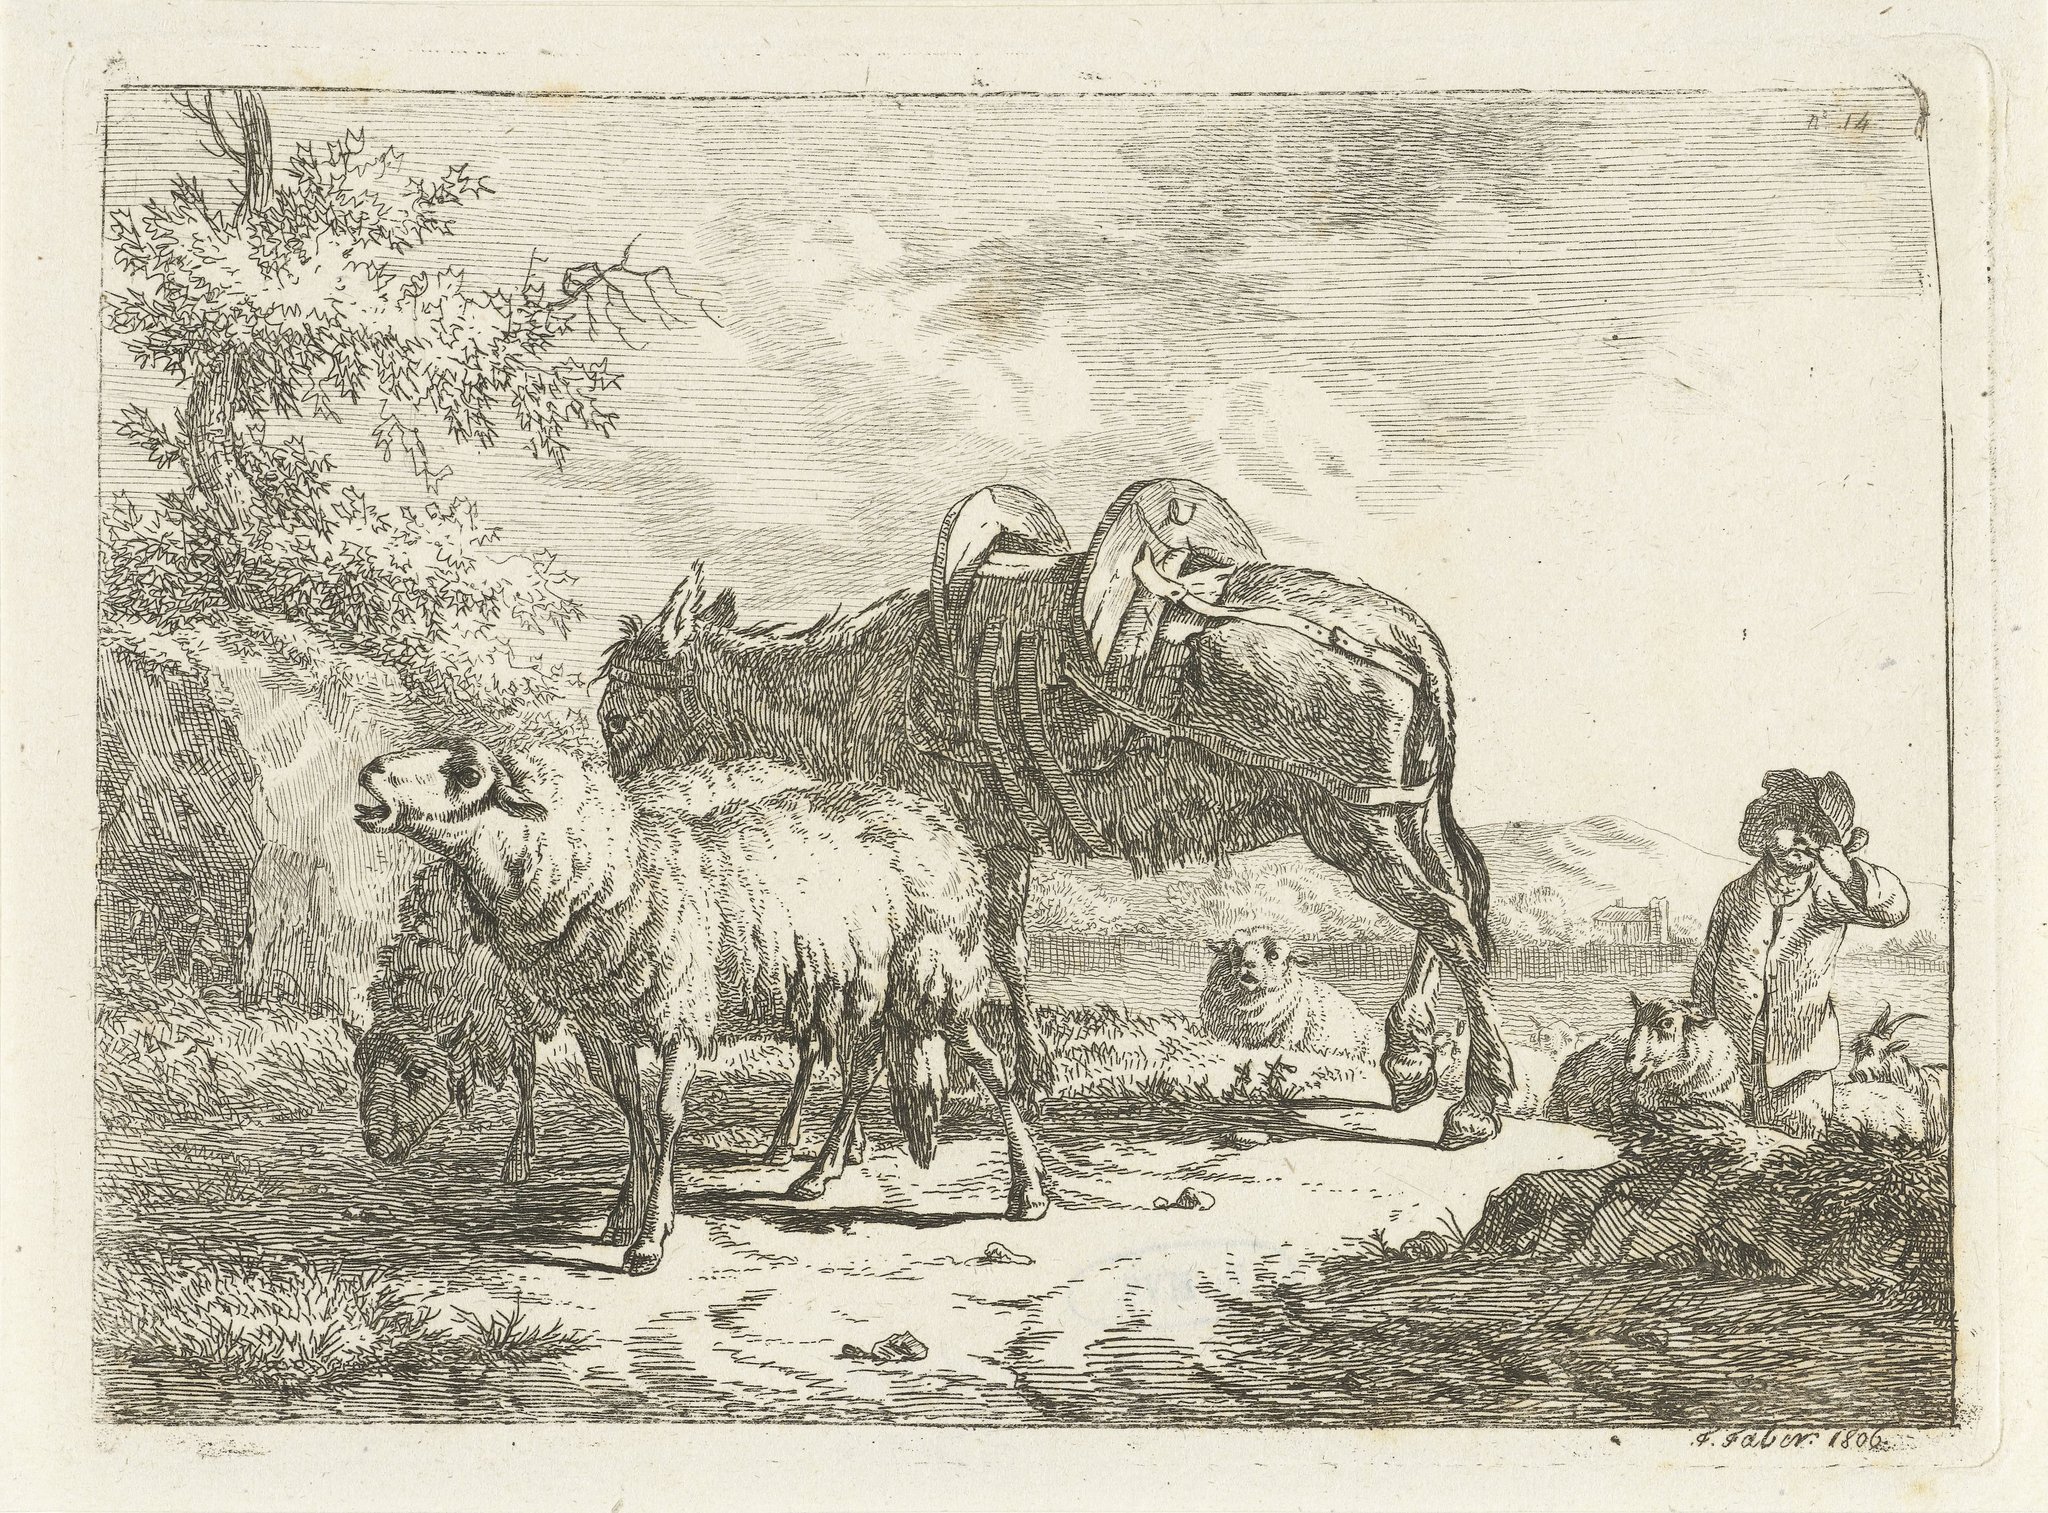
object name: print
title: Herder met schapen en een ezel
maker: frédéric théodore faber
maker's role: print maker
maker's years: 1782-1844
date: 1806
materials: paper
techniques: etching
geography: brussels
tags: ass, donkey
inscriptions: collector's mark: Lugt 2228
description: Een herder loopt met zijn kudde schapen een heuvel op. Op de voorgrond staan twee schapen en een gezadelde ezel.